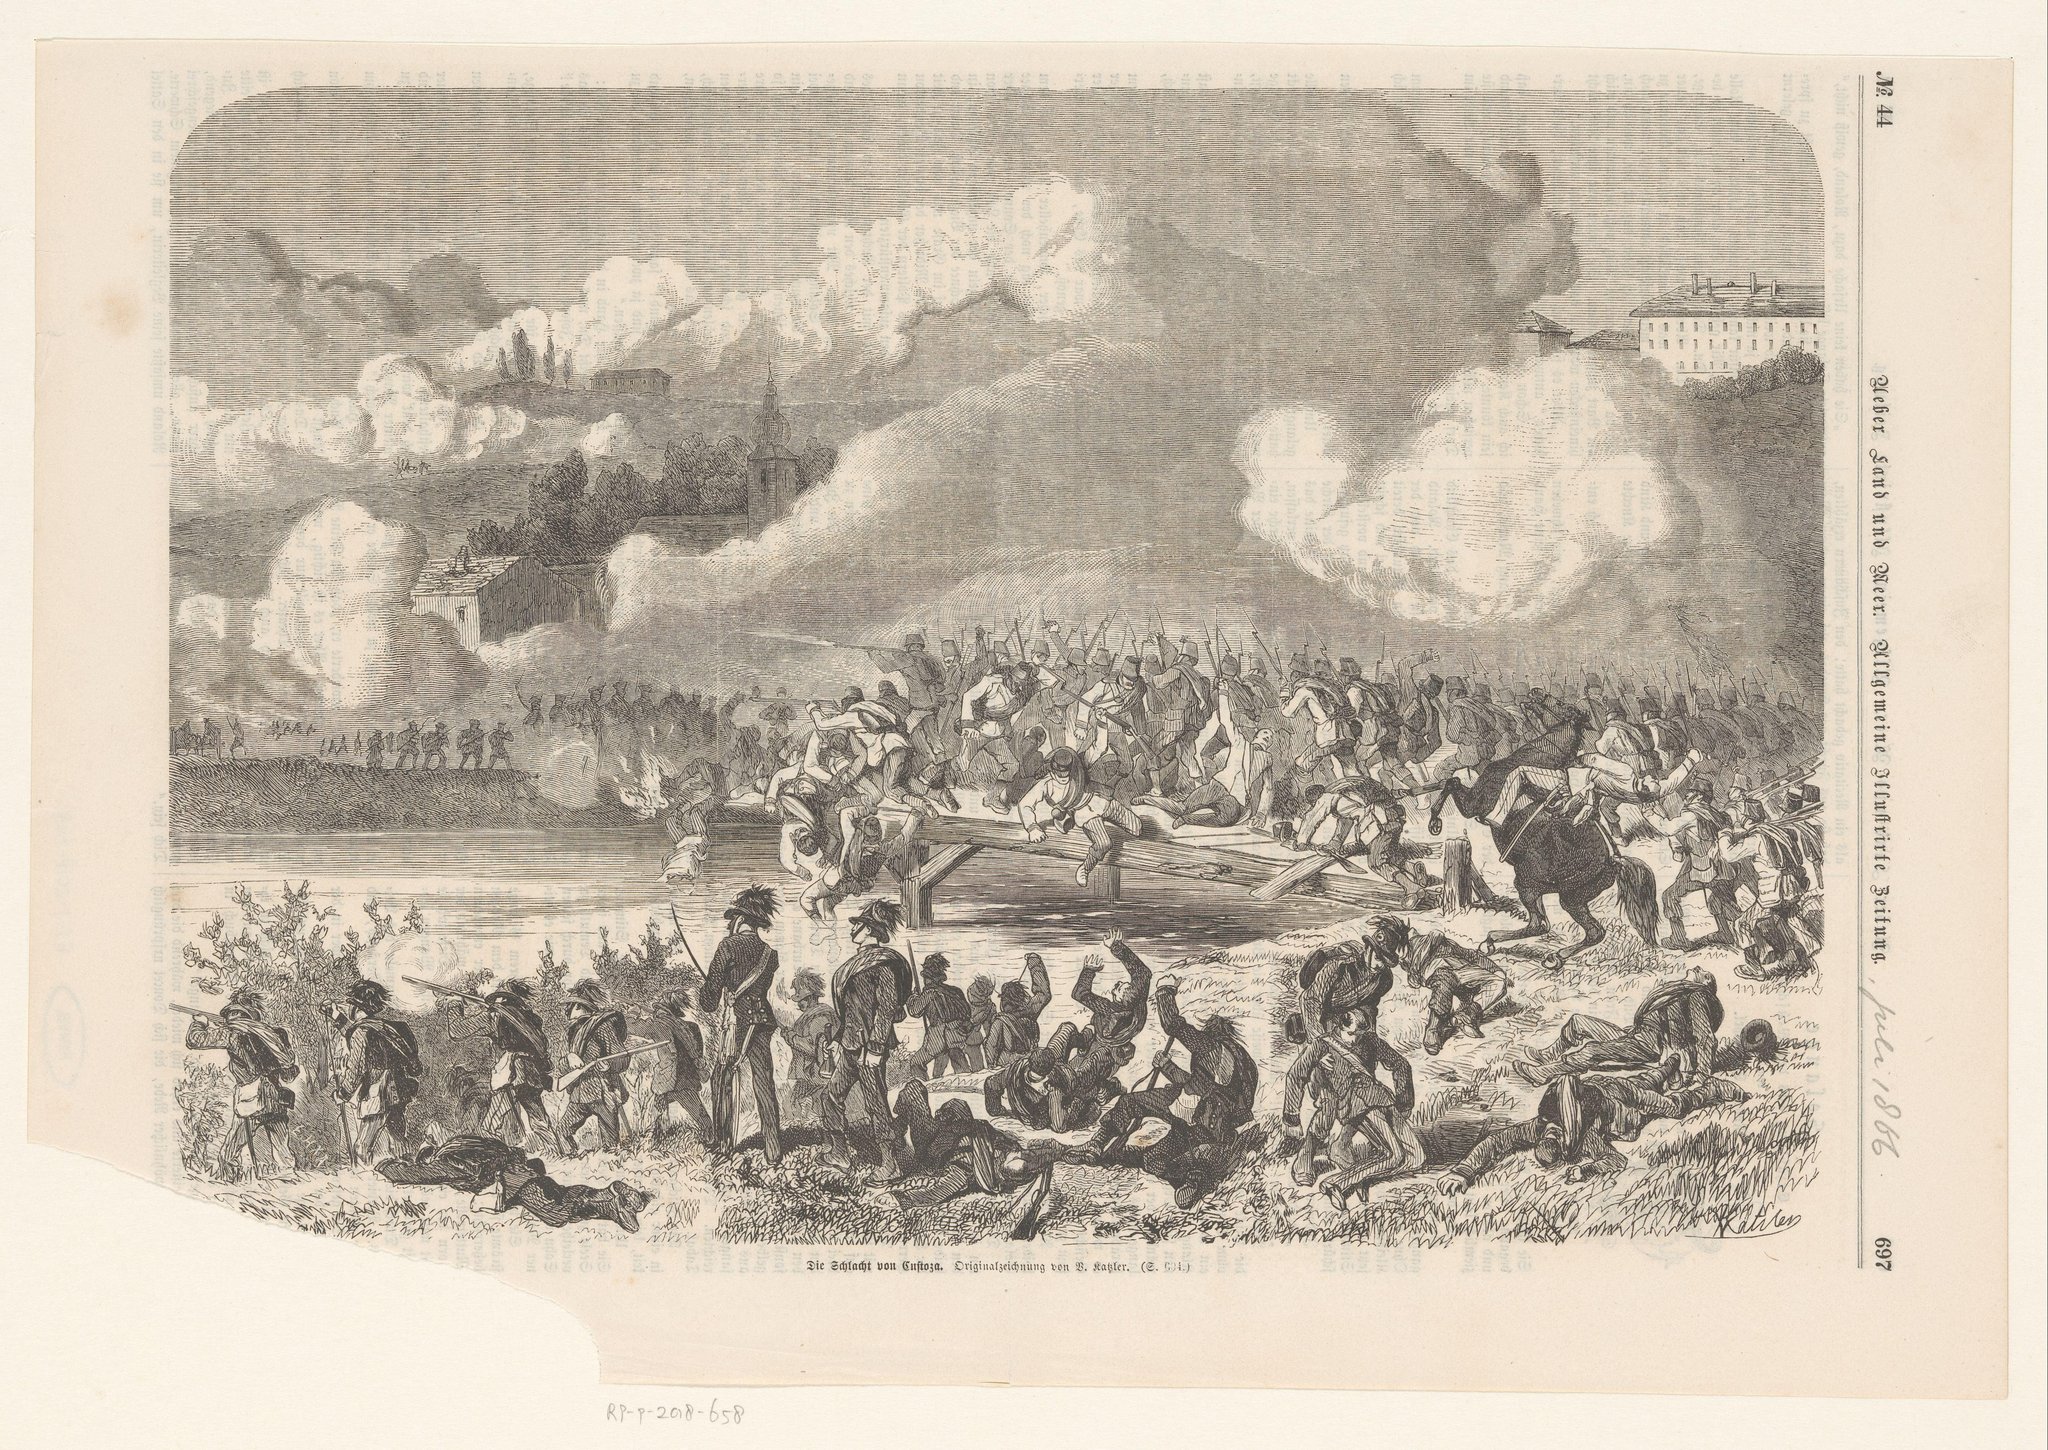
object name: print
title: Slag bij Custoza, 1866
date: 1807-1866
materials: paper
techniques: engraving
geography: germany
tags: battle (+ land forces)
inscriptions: collector's mark: Lugt 2228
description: Slag bij Custoza, 24 juni 1866, tussen Italiaanse en Oostenrijkse troepen. Scène uit de Derde Italiaanse Onafhankelijkheidsoorlog, onderdeel van de Oostenrijks-Pruisische Oorlog van 1866.